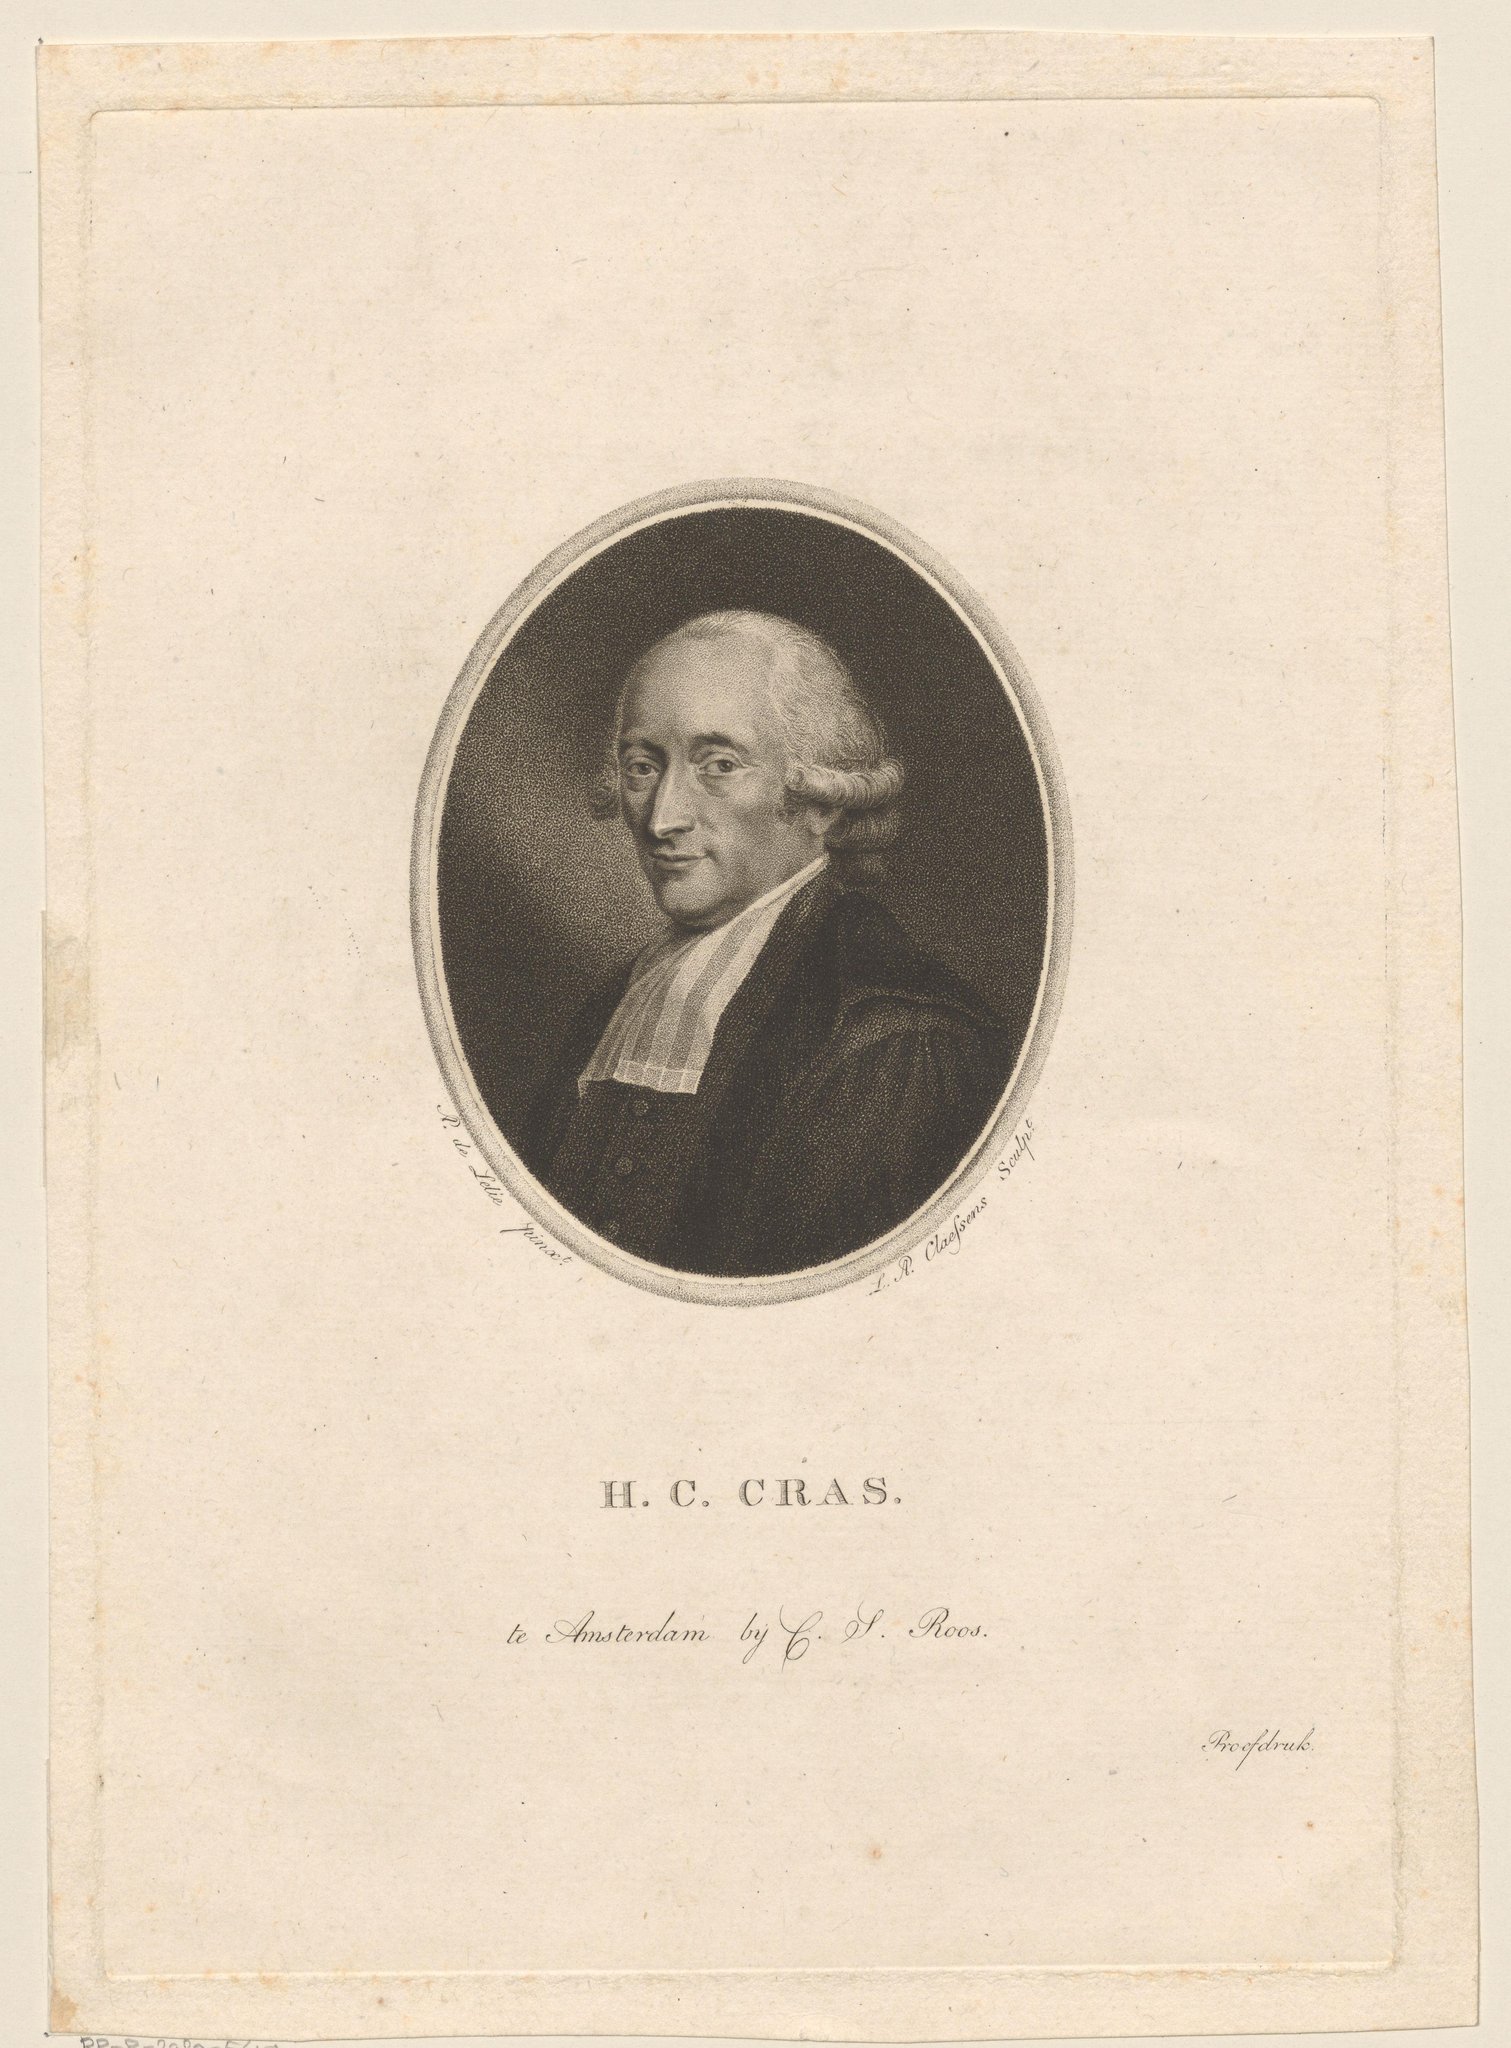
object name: print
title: Portret van Hendrik Constantijn Cras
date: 1773-1834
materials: paper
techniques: engraving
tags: leiden, amsterdam, historical persons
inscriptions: : Lugt 2228